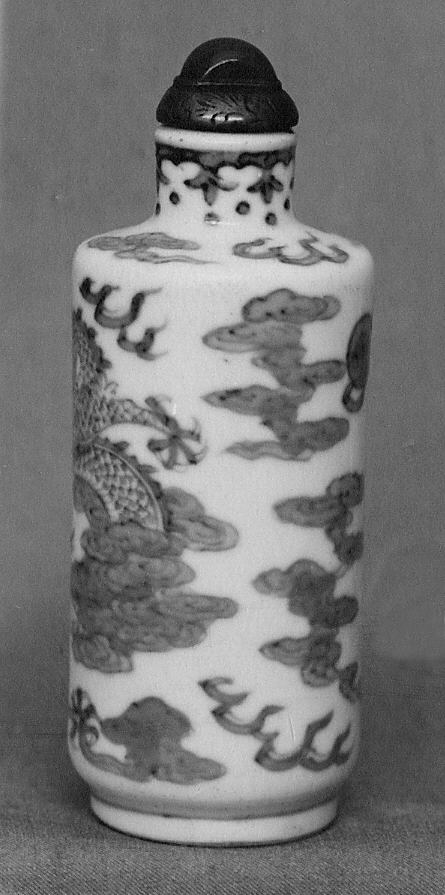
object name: snuff bottle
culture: chinese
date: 1736-1795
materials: paste, porcelain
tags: dragons